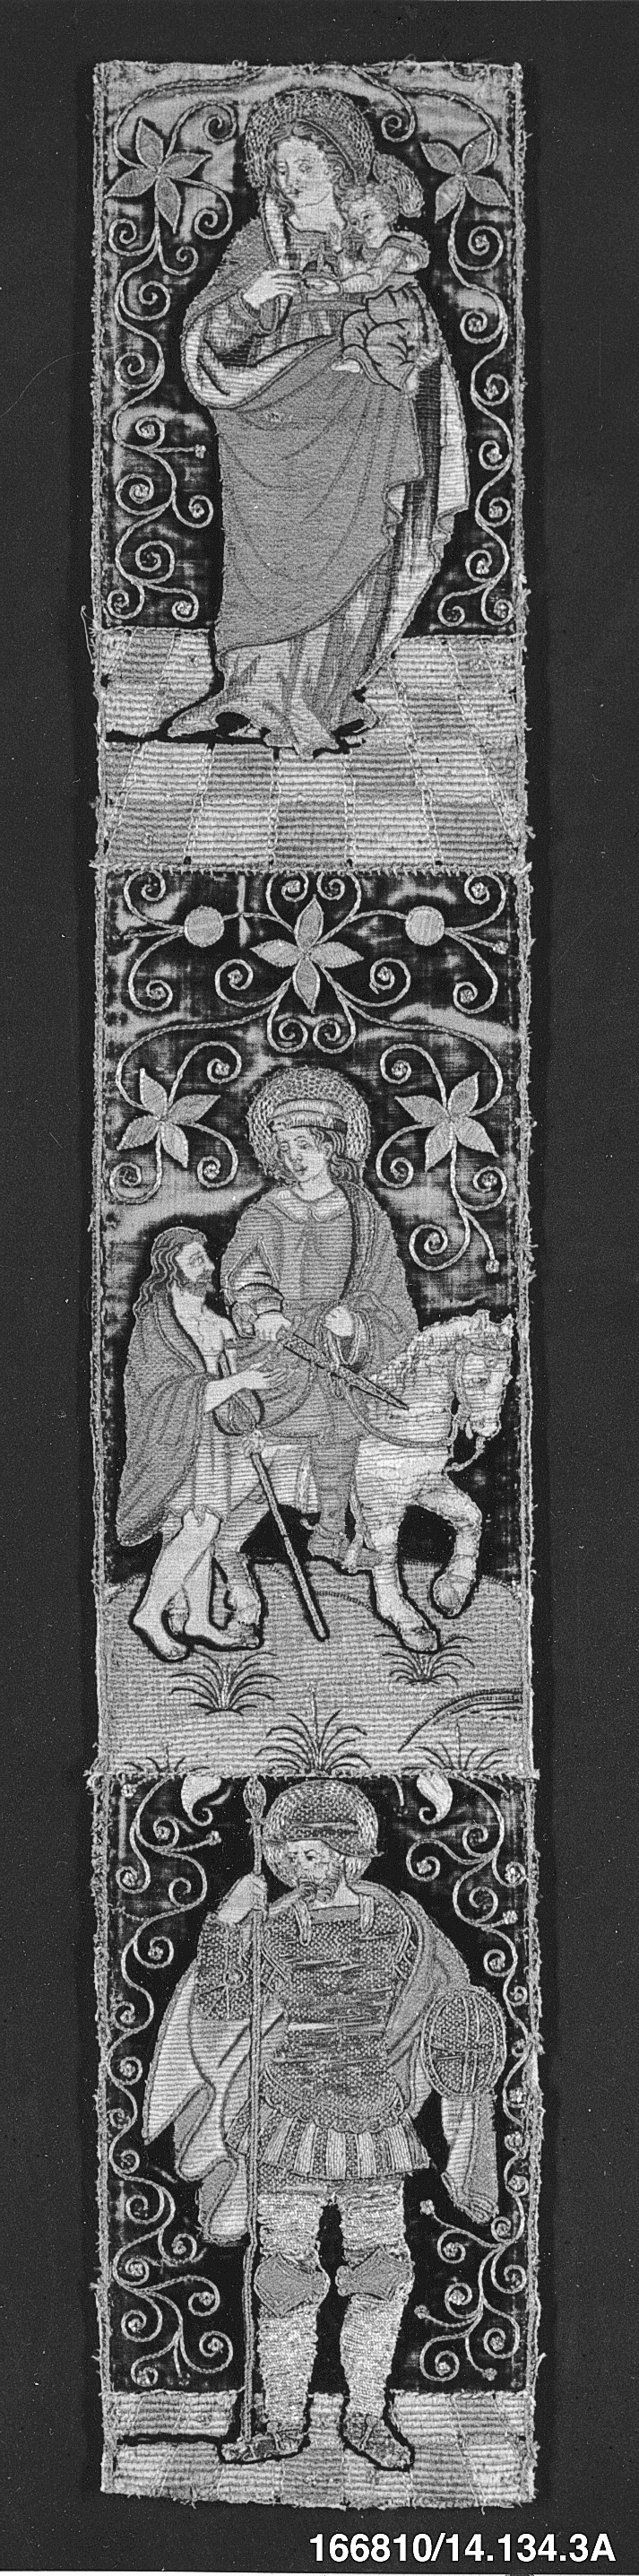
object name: orphrey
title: Orphrey (one of a pair)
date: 1601-1700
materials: metal thread, silk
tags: horses,madonna and child